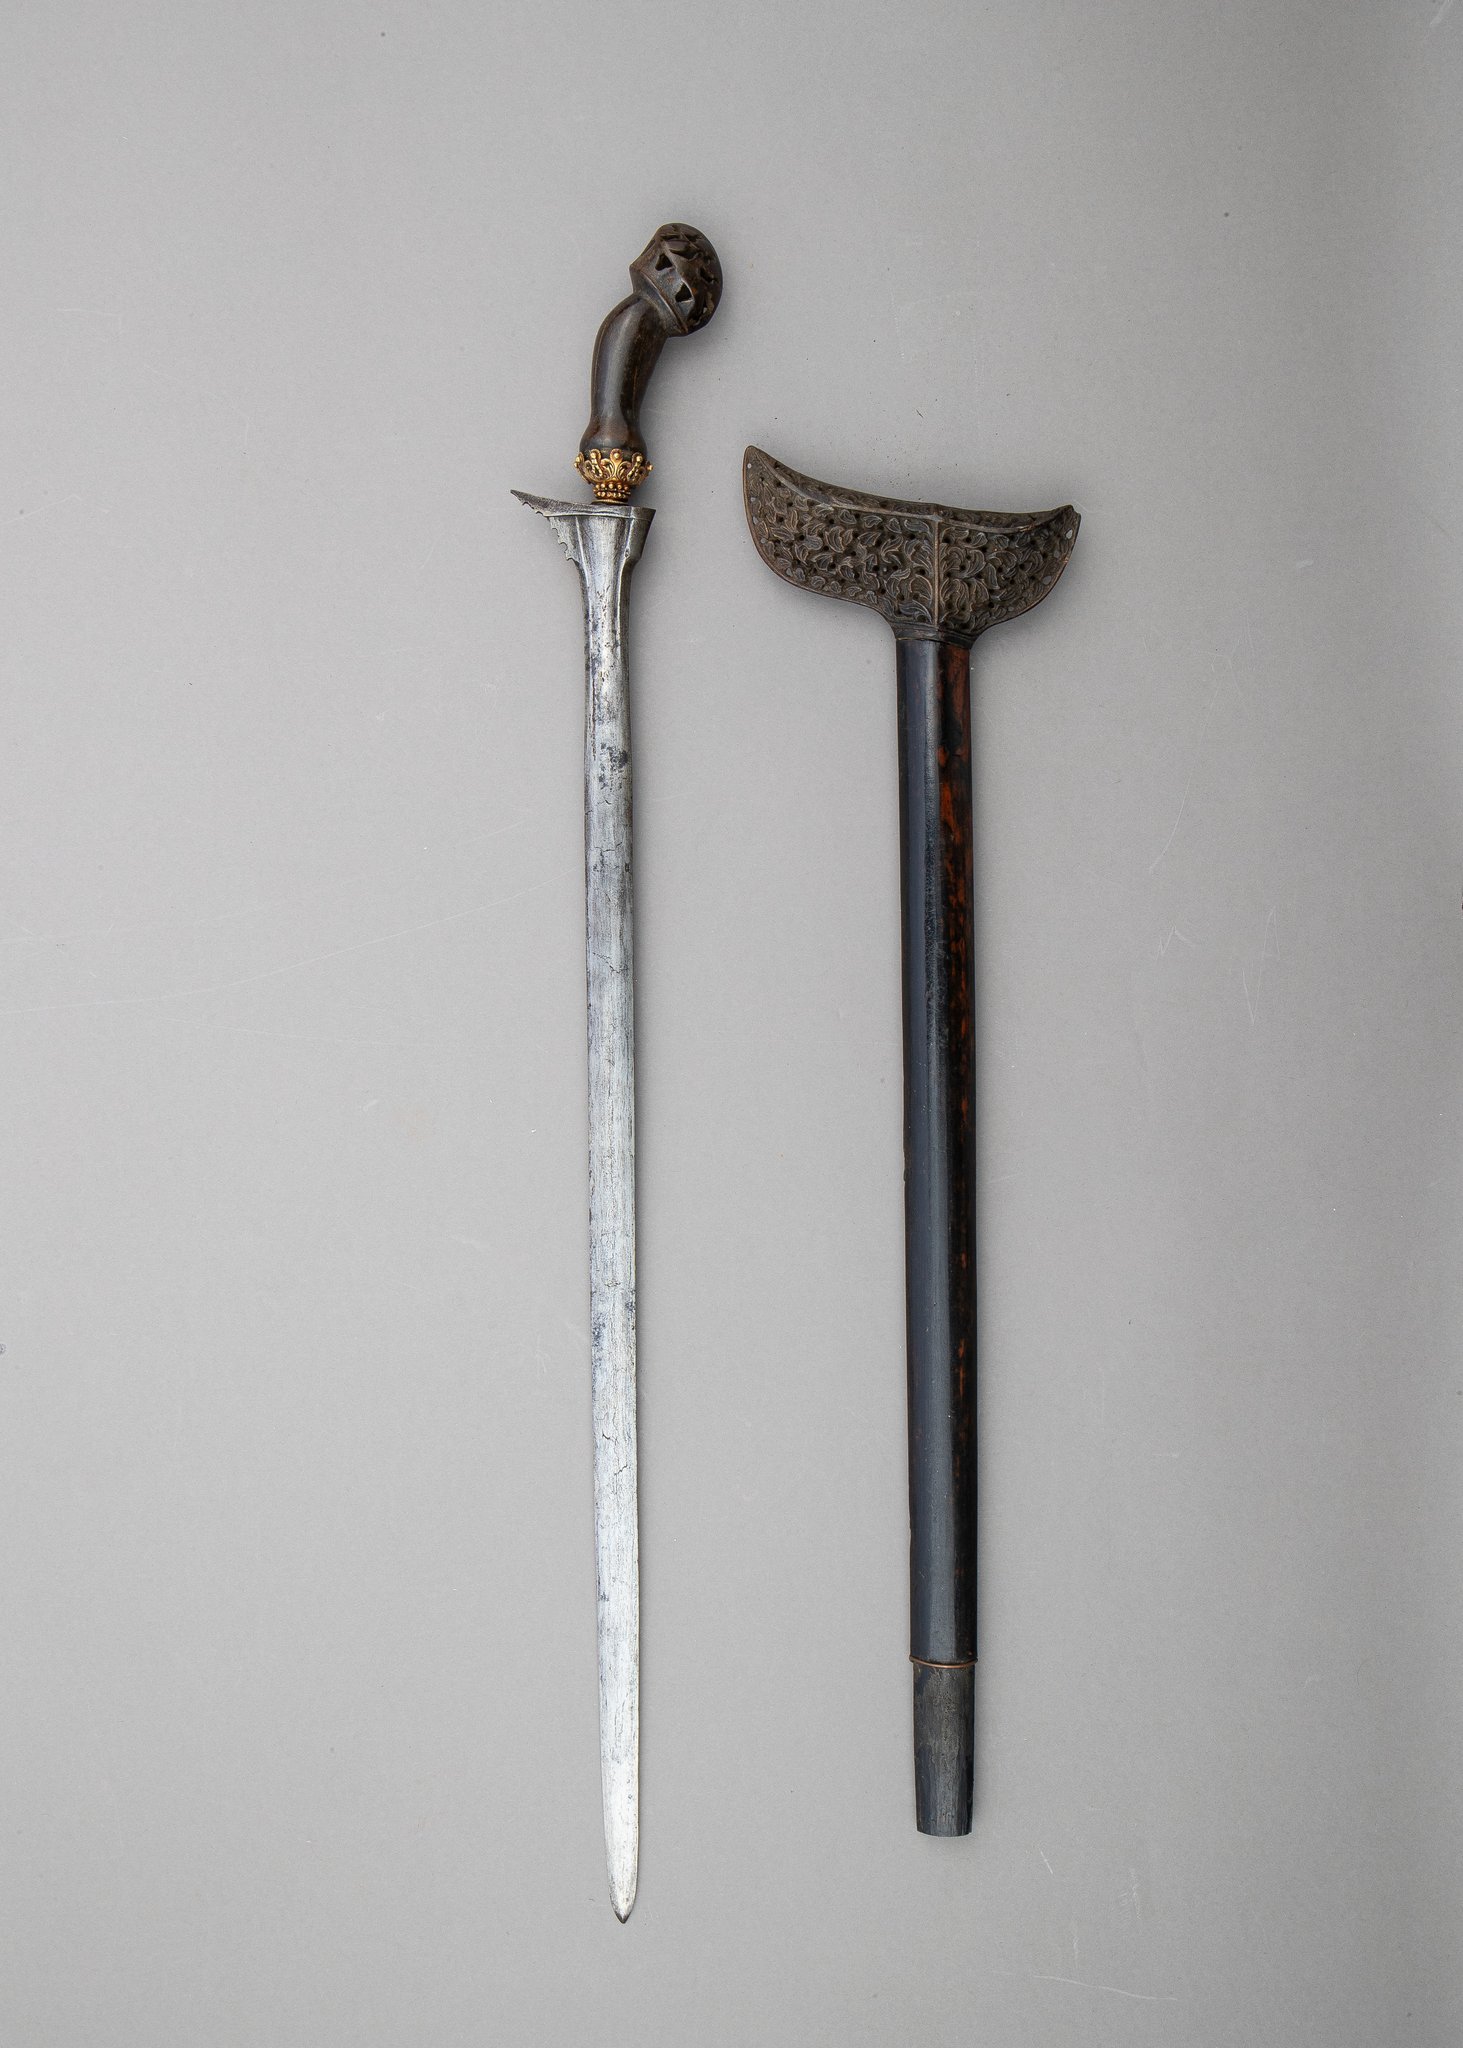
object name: executioner's kris with sheath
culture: malayan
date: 1701-1900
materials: gold, horn, steel, wood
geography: malay peninsula